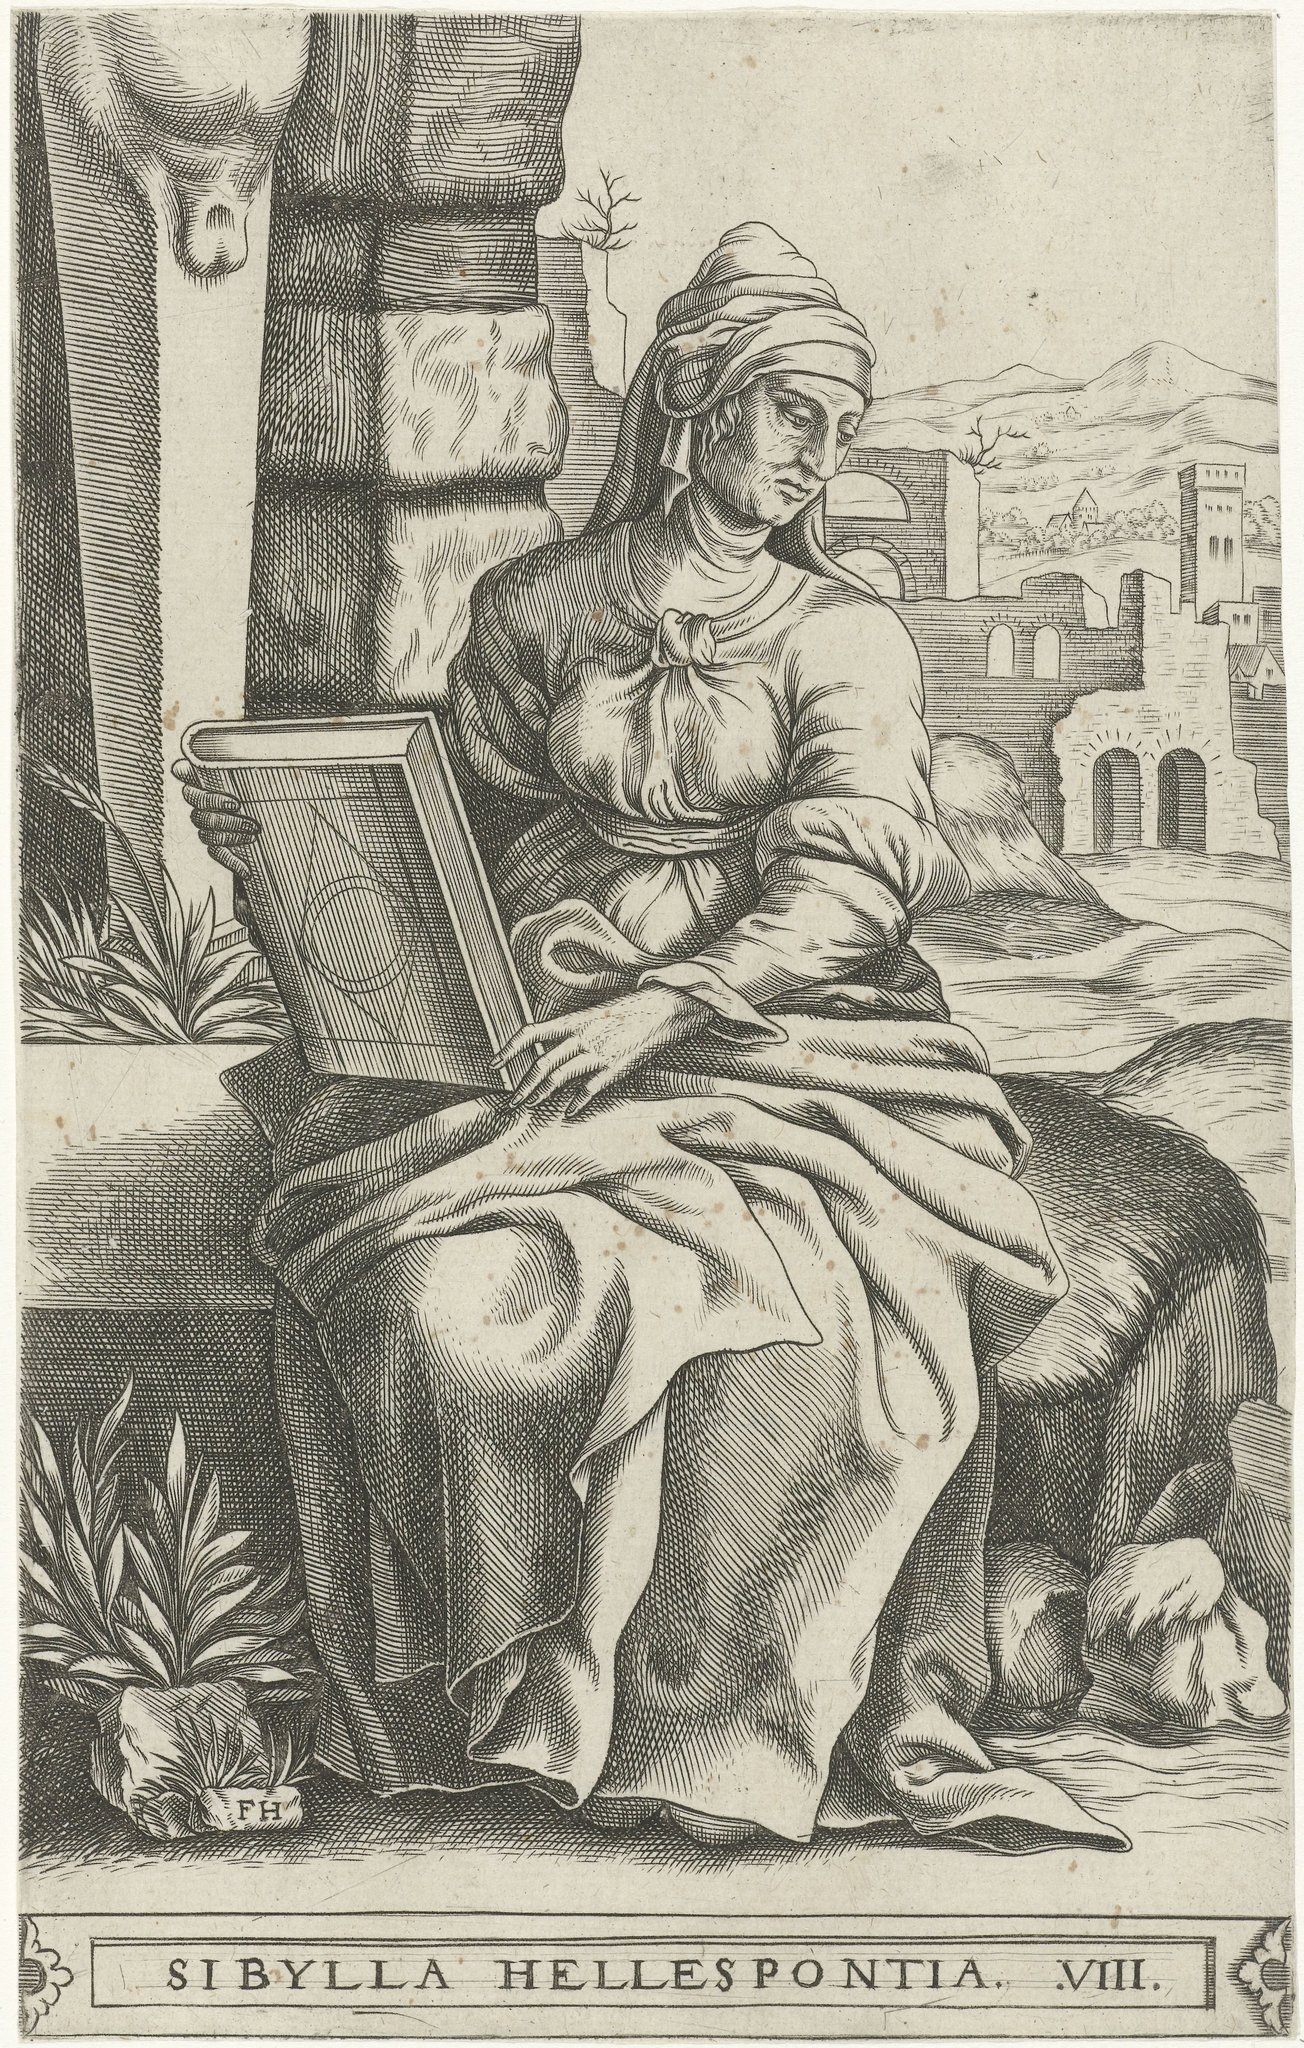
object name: print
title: Hellespontische Sibille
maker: frans huys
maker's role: print maker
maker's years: 1522-1562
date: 1546-1562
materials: paper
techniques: engraving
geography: antwerp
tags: sibyls (with name)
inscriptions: collector's mark: Lugt 2228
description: De Hellespontische Sibille zittend met een boek in haar handen. Op de achtergrond rechts de ruïne en daarachter een stad in een landschap. De prent maakt deel uit van een tiendelige serie over de Sibillen.